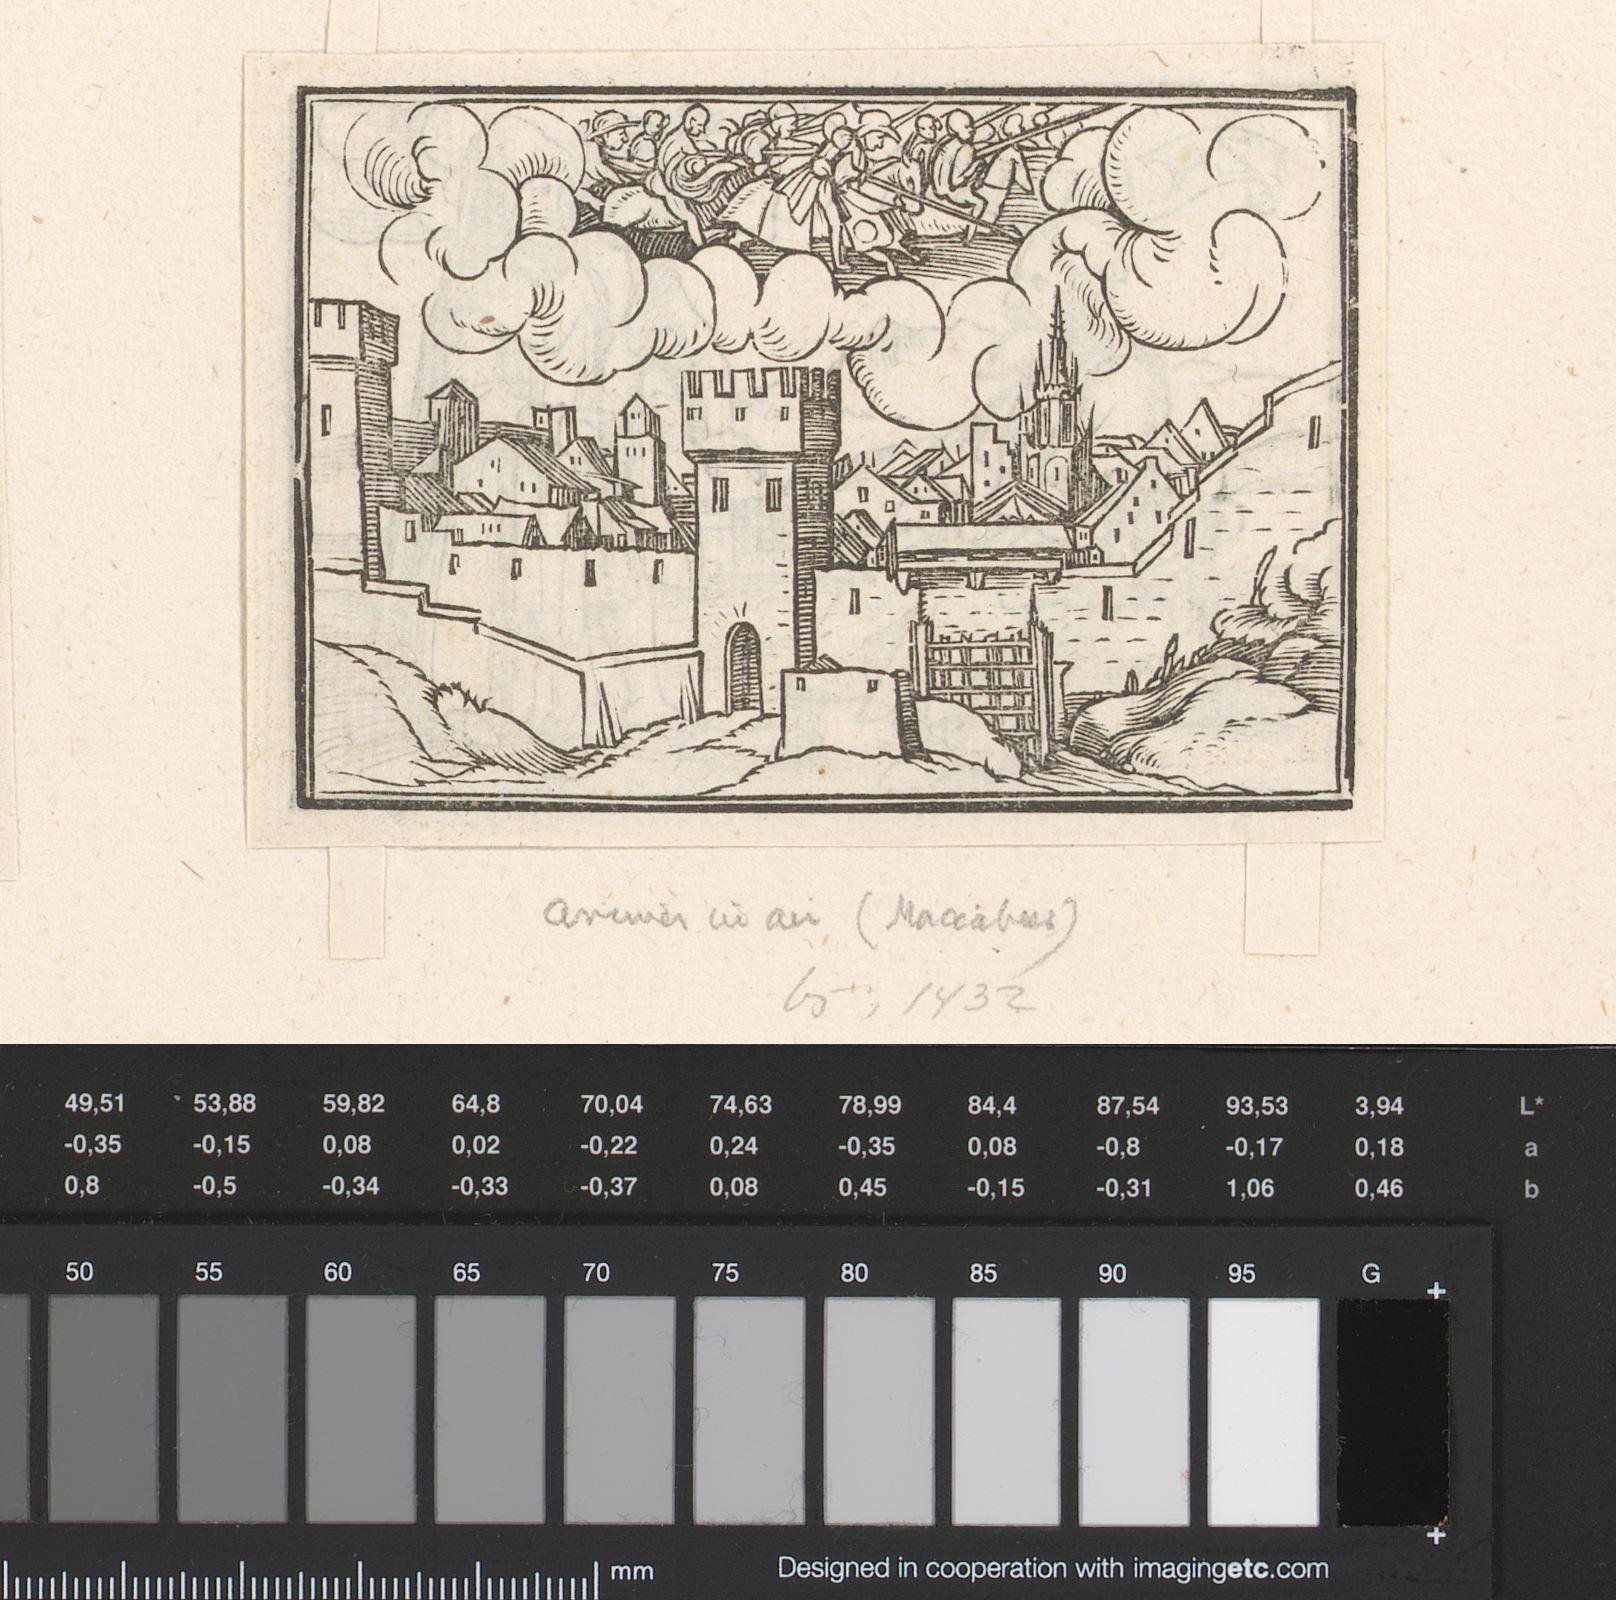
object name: print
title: Geschiedenis van het Oude Testament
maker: veit rudolf specklin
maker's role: print maker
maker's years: -1550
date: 1538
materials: paper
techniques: woodcut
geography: switzerland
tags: riders are seen in the sky above the city of jerusalem (2 maccabees 5:2)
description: Boekillustratie voor het eerst gebruikt in: Biblia Utriusque Testamenti iuxta Vulgatam Translationem, Lyon, M. en G. Trechsel (voor Hugo à Porta) 1538. Later in verschillende uitgaven opnieuw gebruikt. Deze prent vermoedelijk gebruikt in één van de uitgaven uitgegeven en/of gedrukt door Jean Frellon, Lyon.